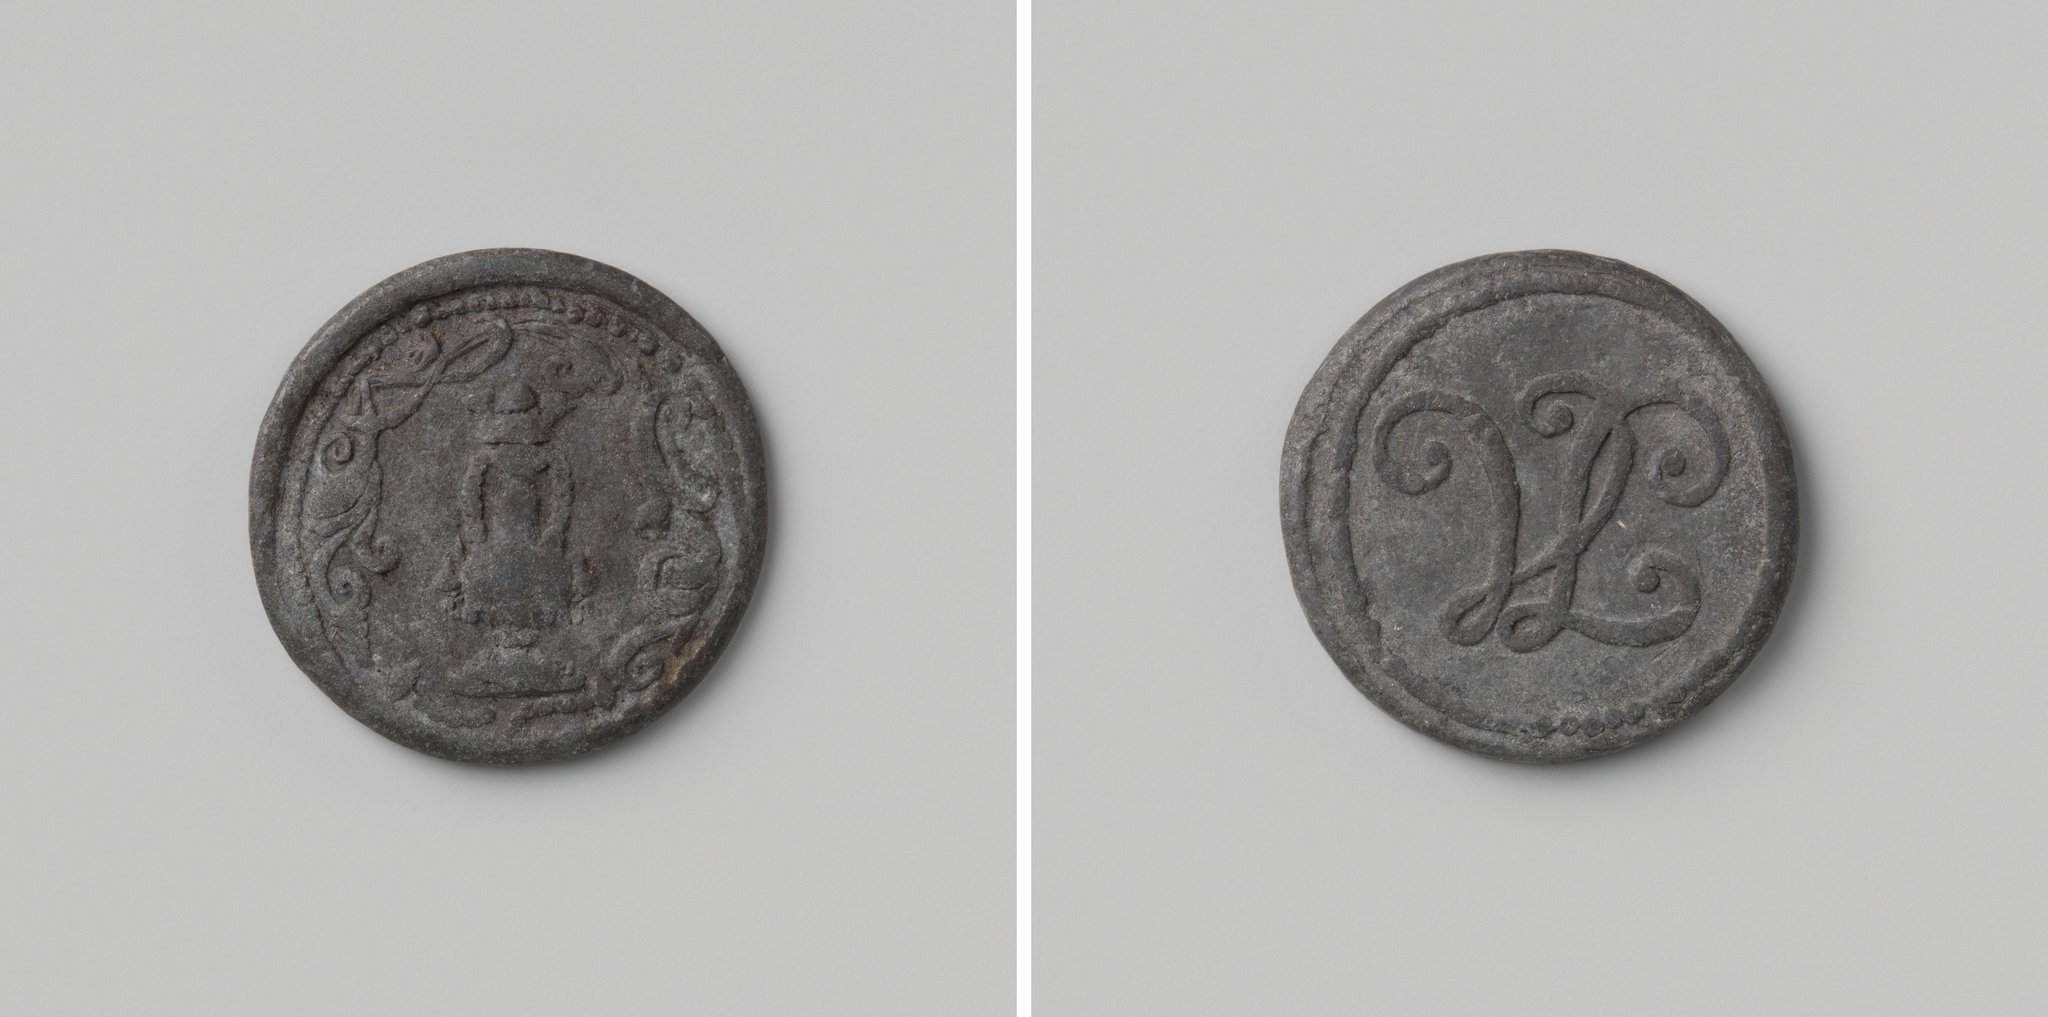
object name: council medal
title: Vroedschap van Zierikzee, penning ter waarde van 5 stuivers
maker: Anonymous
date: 1700-1800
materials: lead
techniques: striking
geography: zierikzee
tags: zierikzee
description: Loden penning. Voorzijde: fles binnen bloemenkrans. Keerzijde: letters V en L, sierlijk door elkaar geschreven